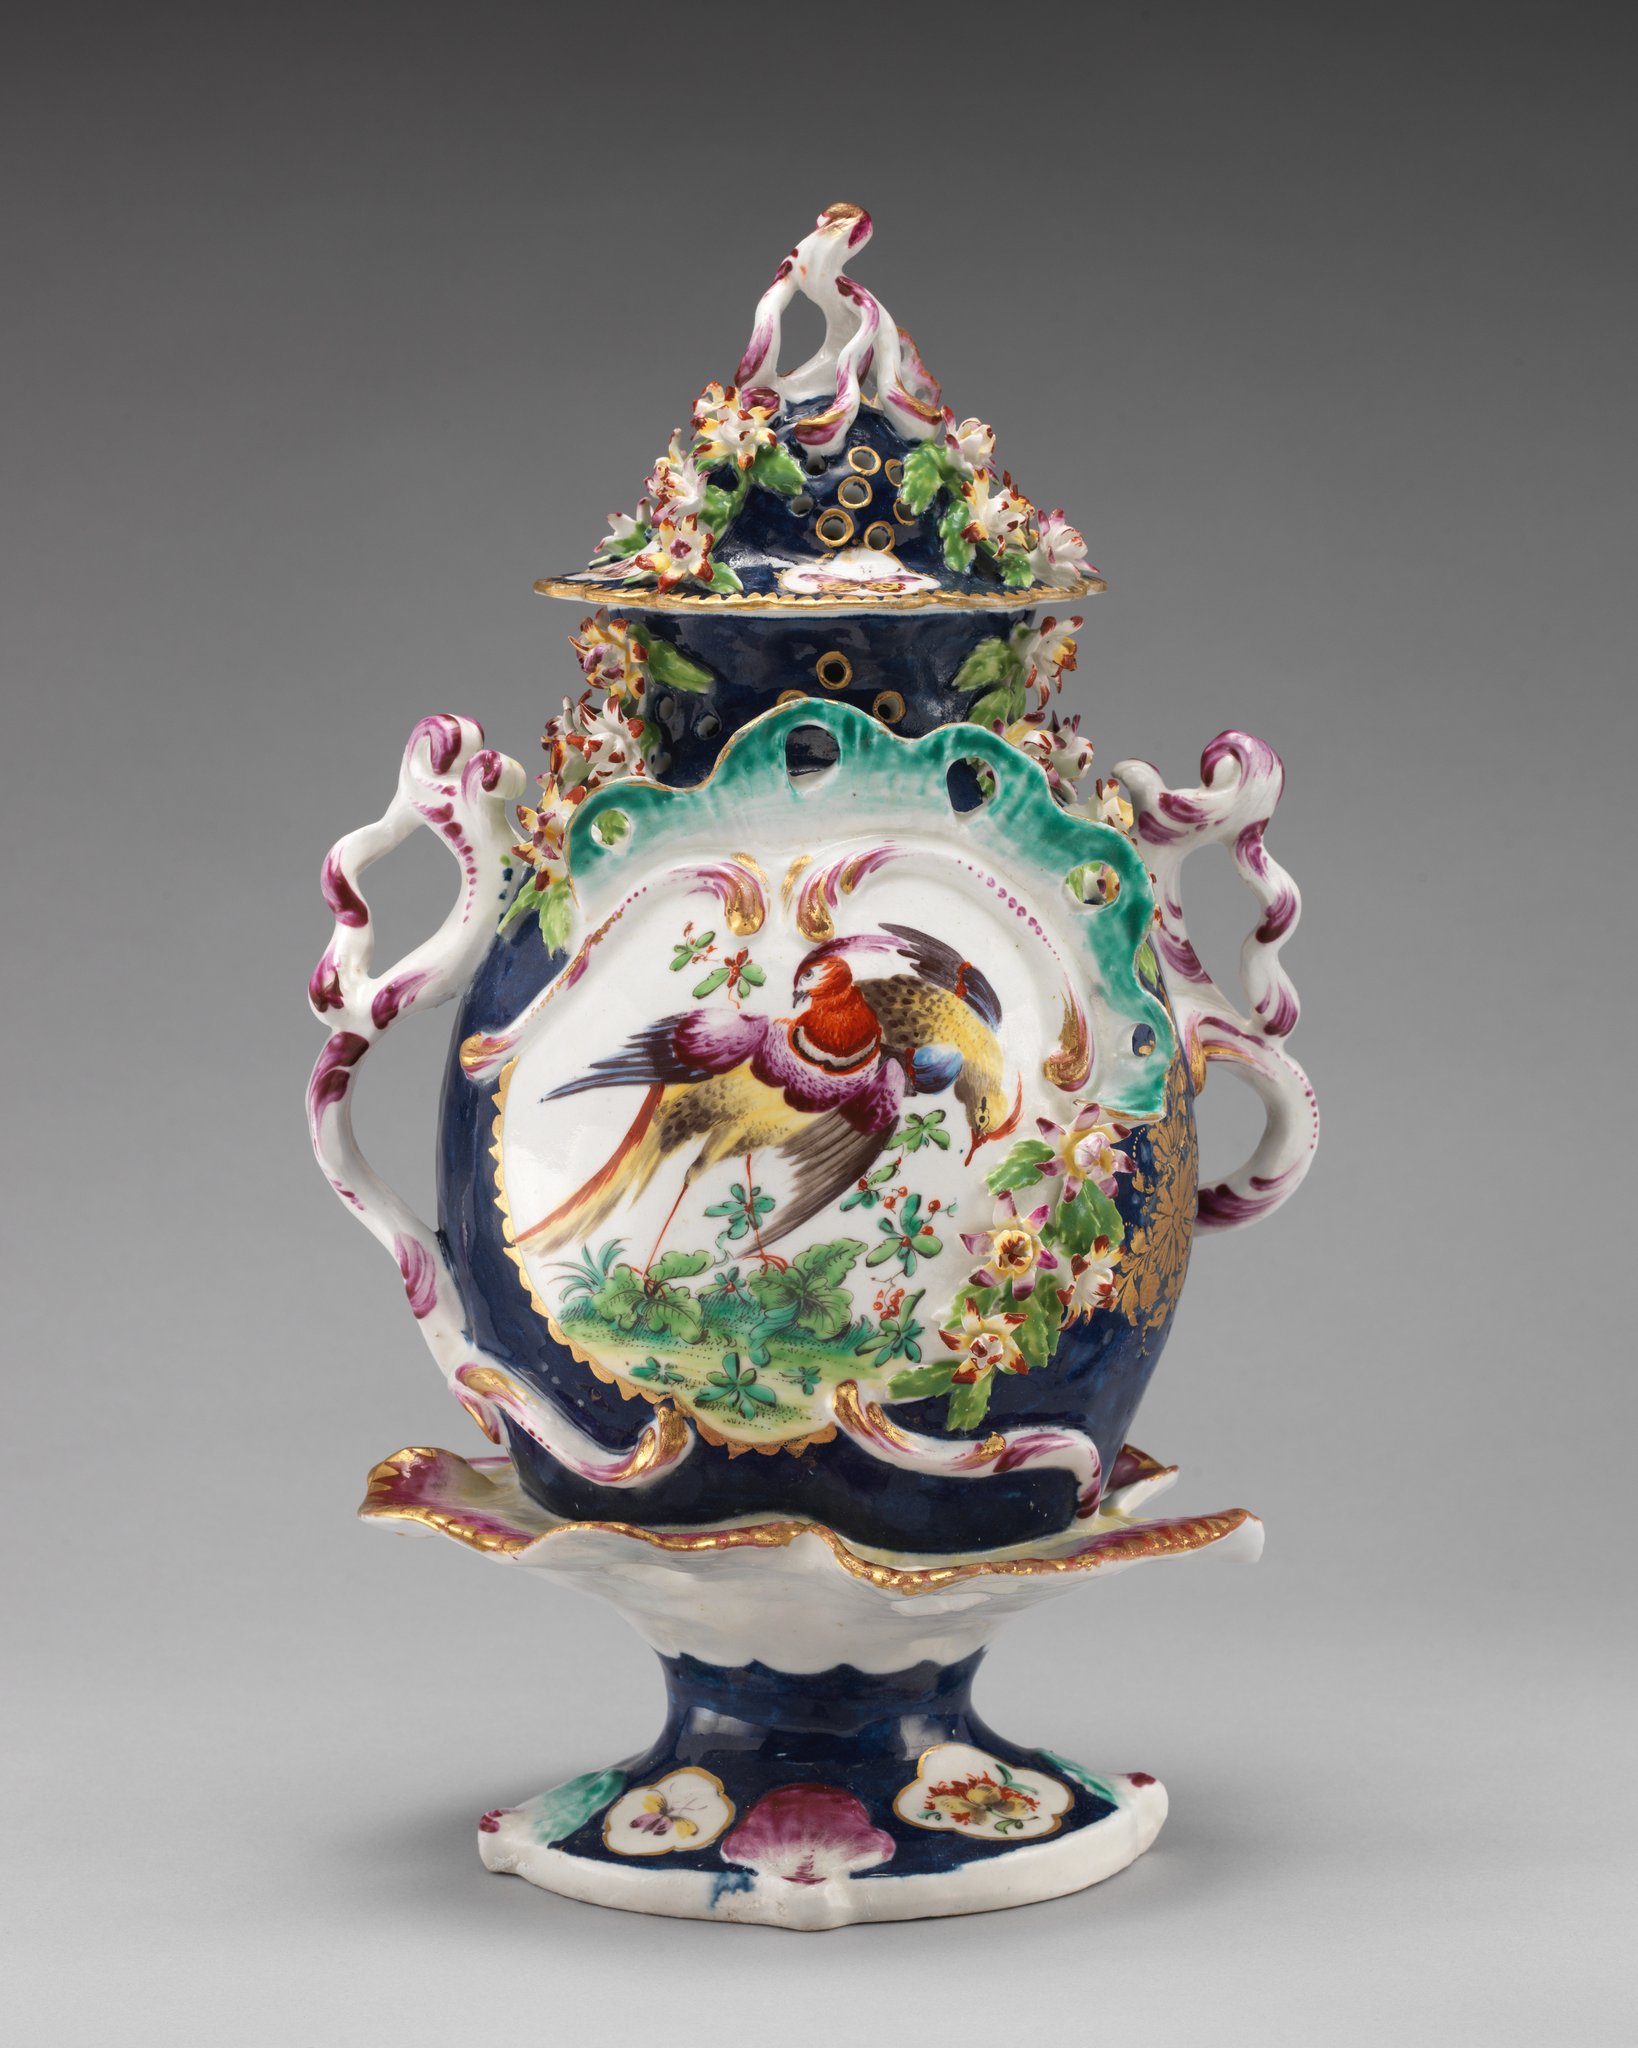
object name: vase with cover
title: Vase with cover (part of a garniture)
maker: bow porcelain factory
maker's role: factory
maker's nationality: british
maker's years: 1747-1776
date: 1765-1770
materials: soft paste porcelain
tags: birds,flowers